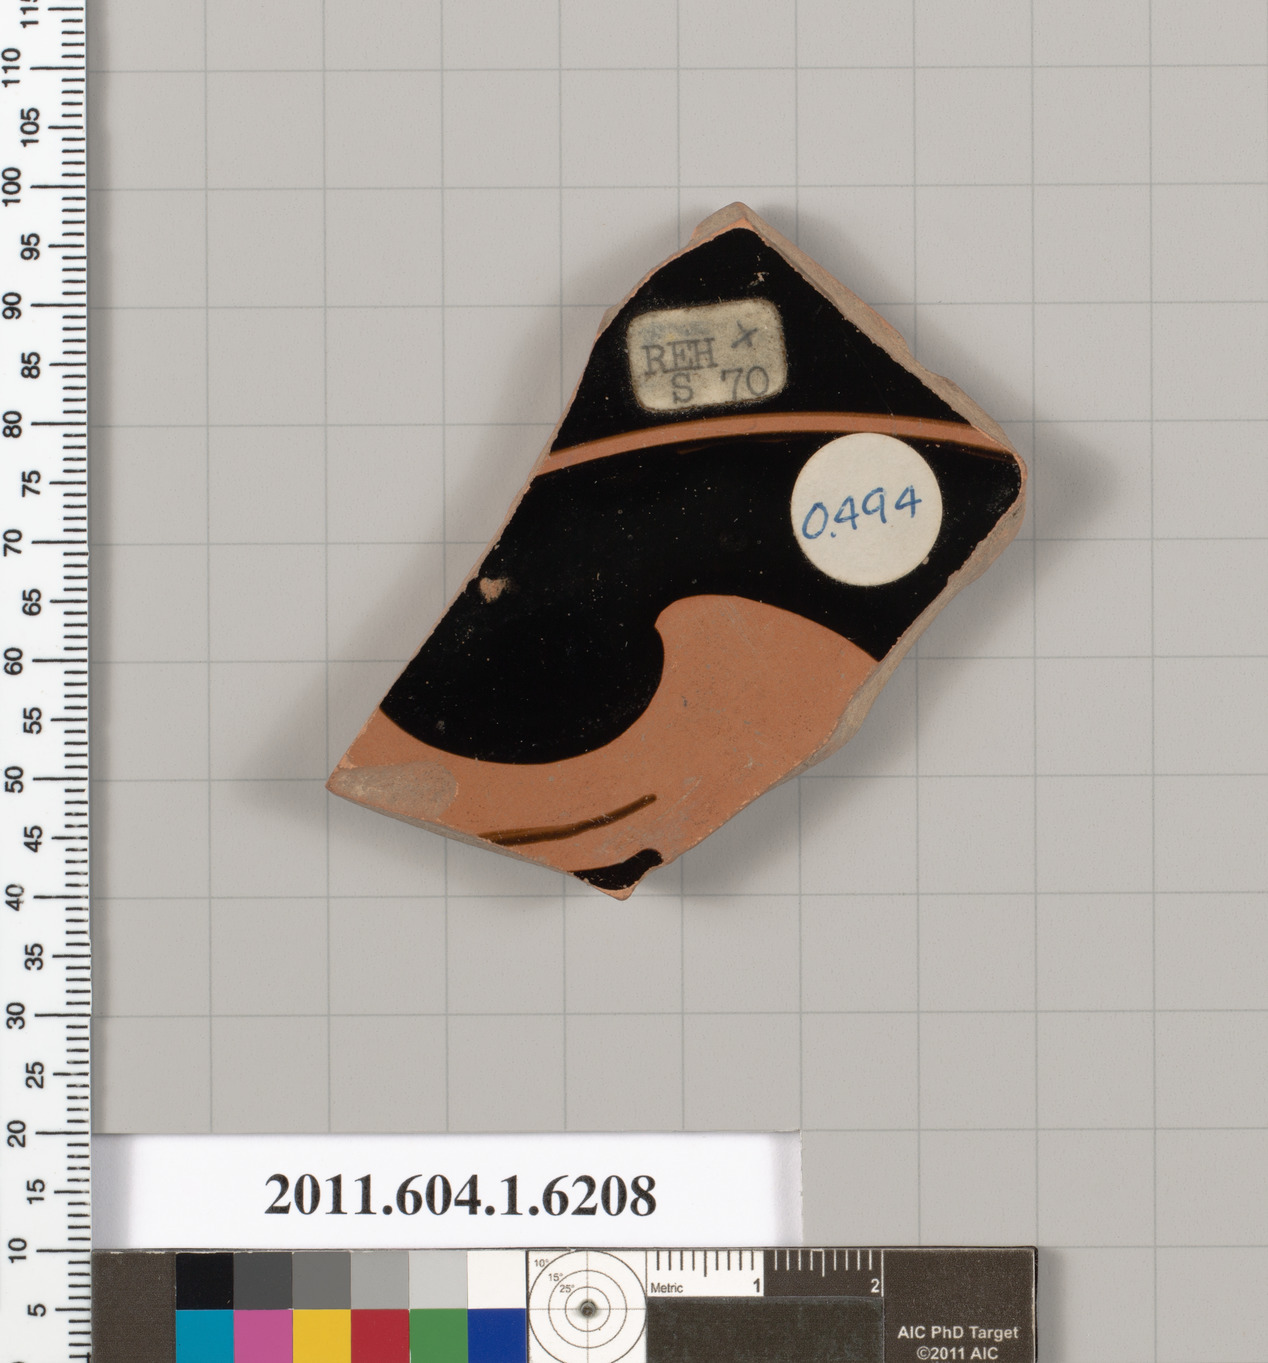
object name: kylix fragment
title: Terracotta fragment of a kylix (drinking cup)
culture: greek, attic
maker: painter of berlin 2268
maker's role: artist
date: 510-500 BCE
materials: terracotta